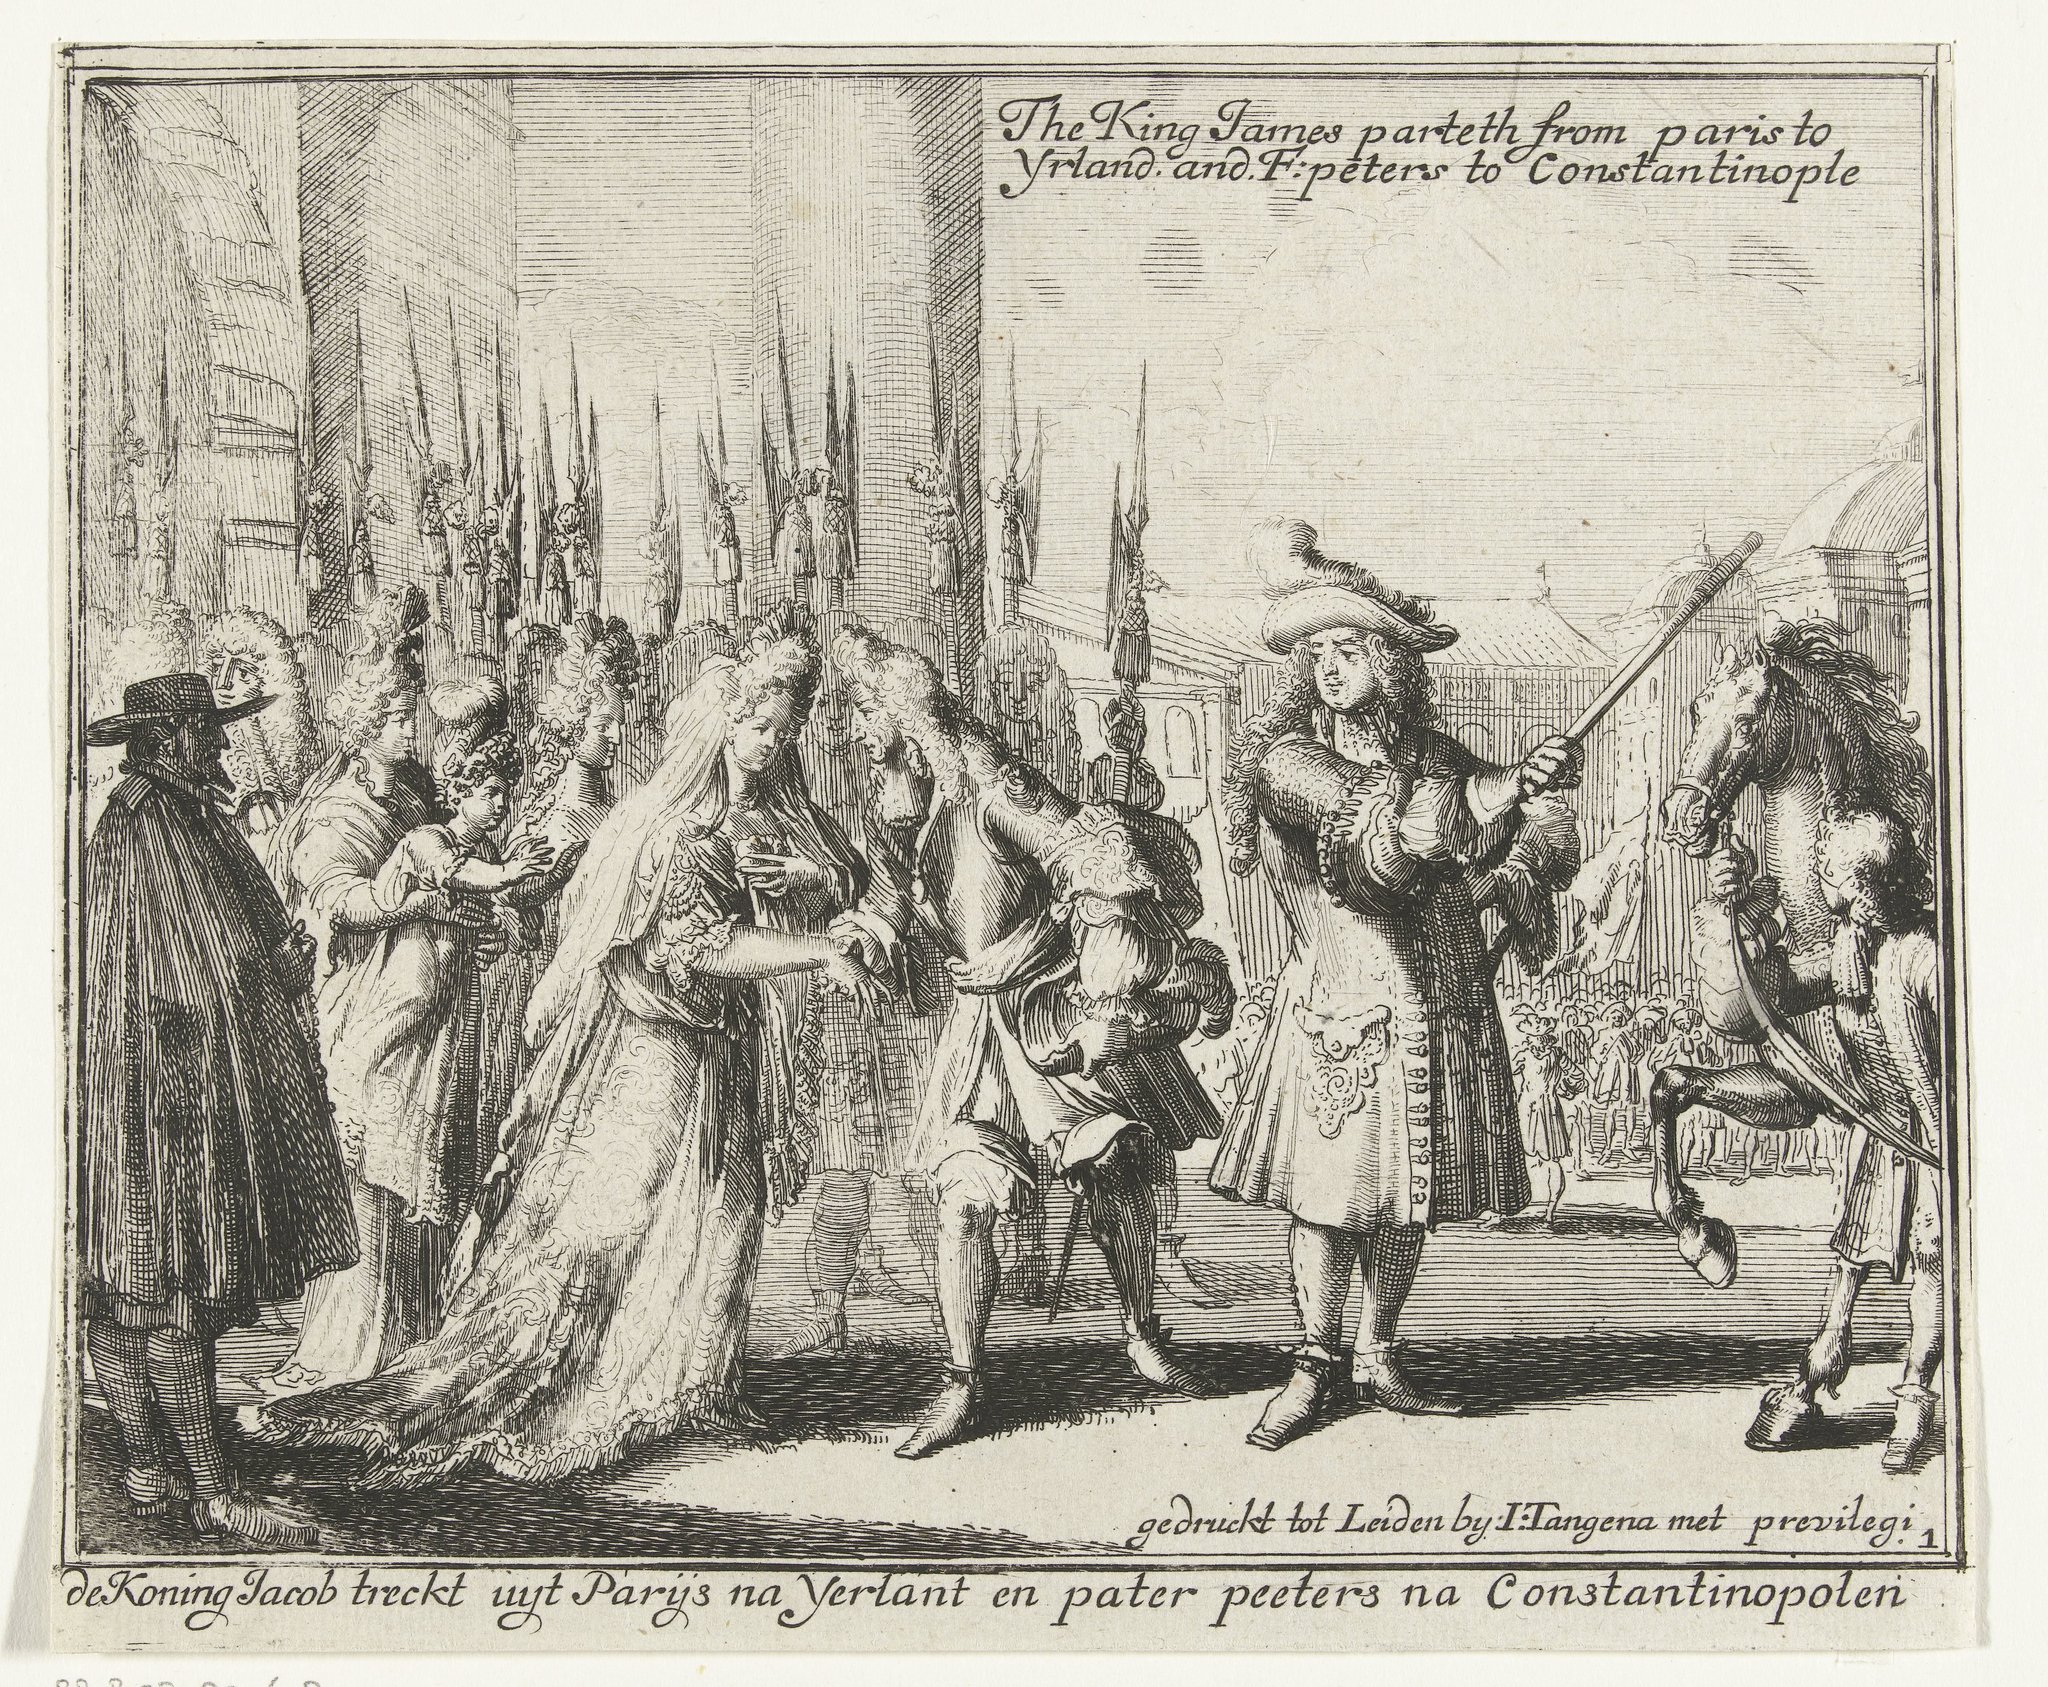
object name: print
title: Koning Jacobus II vertrekt uit Parijs naar Ierland, 1689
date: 1689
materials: paper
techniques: etching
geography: northern netherlands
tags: jacobus ii (koning van engeland en schotland), paris, departure ~ travelling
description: Koning Jacobus II vertrekt uit Parijs naar Ierland, 1689. De koning neemt afscheid van zijn vrouw Maria van Modena, links staat pater Peters klaar om naar Constantinopel te vertrekken. Plaat nr. 1 in een serie over de strijd gevoerd door de afgezette katholieke koning Jacobus II van Engeland tegen het Engelse leger in Ierland in 1689.